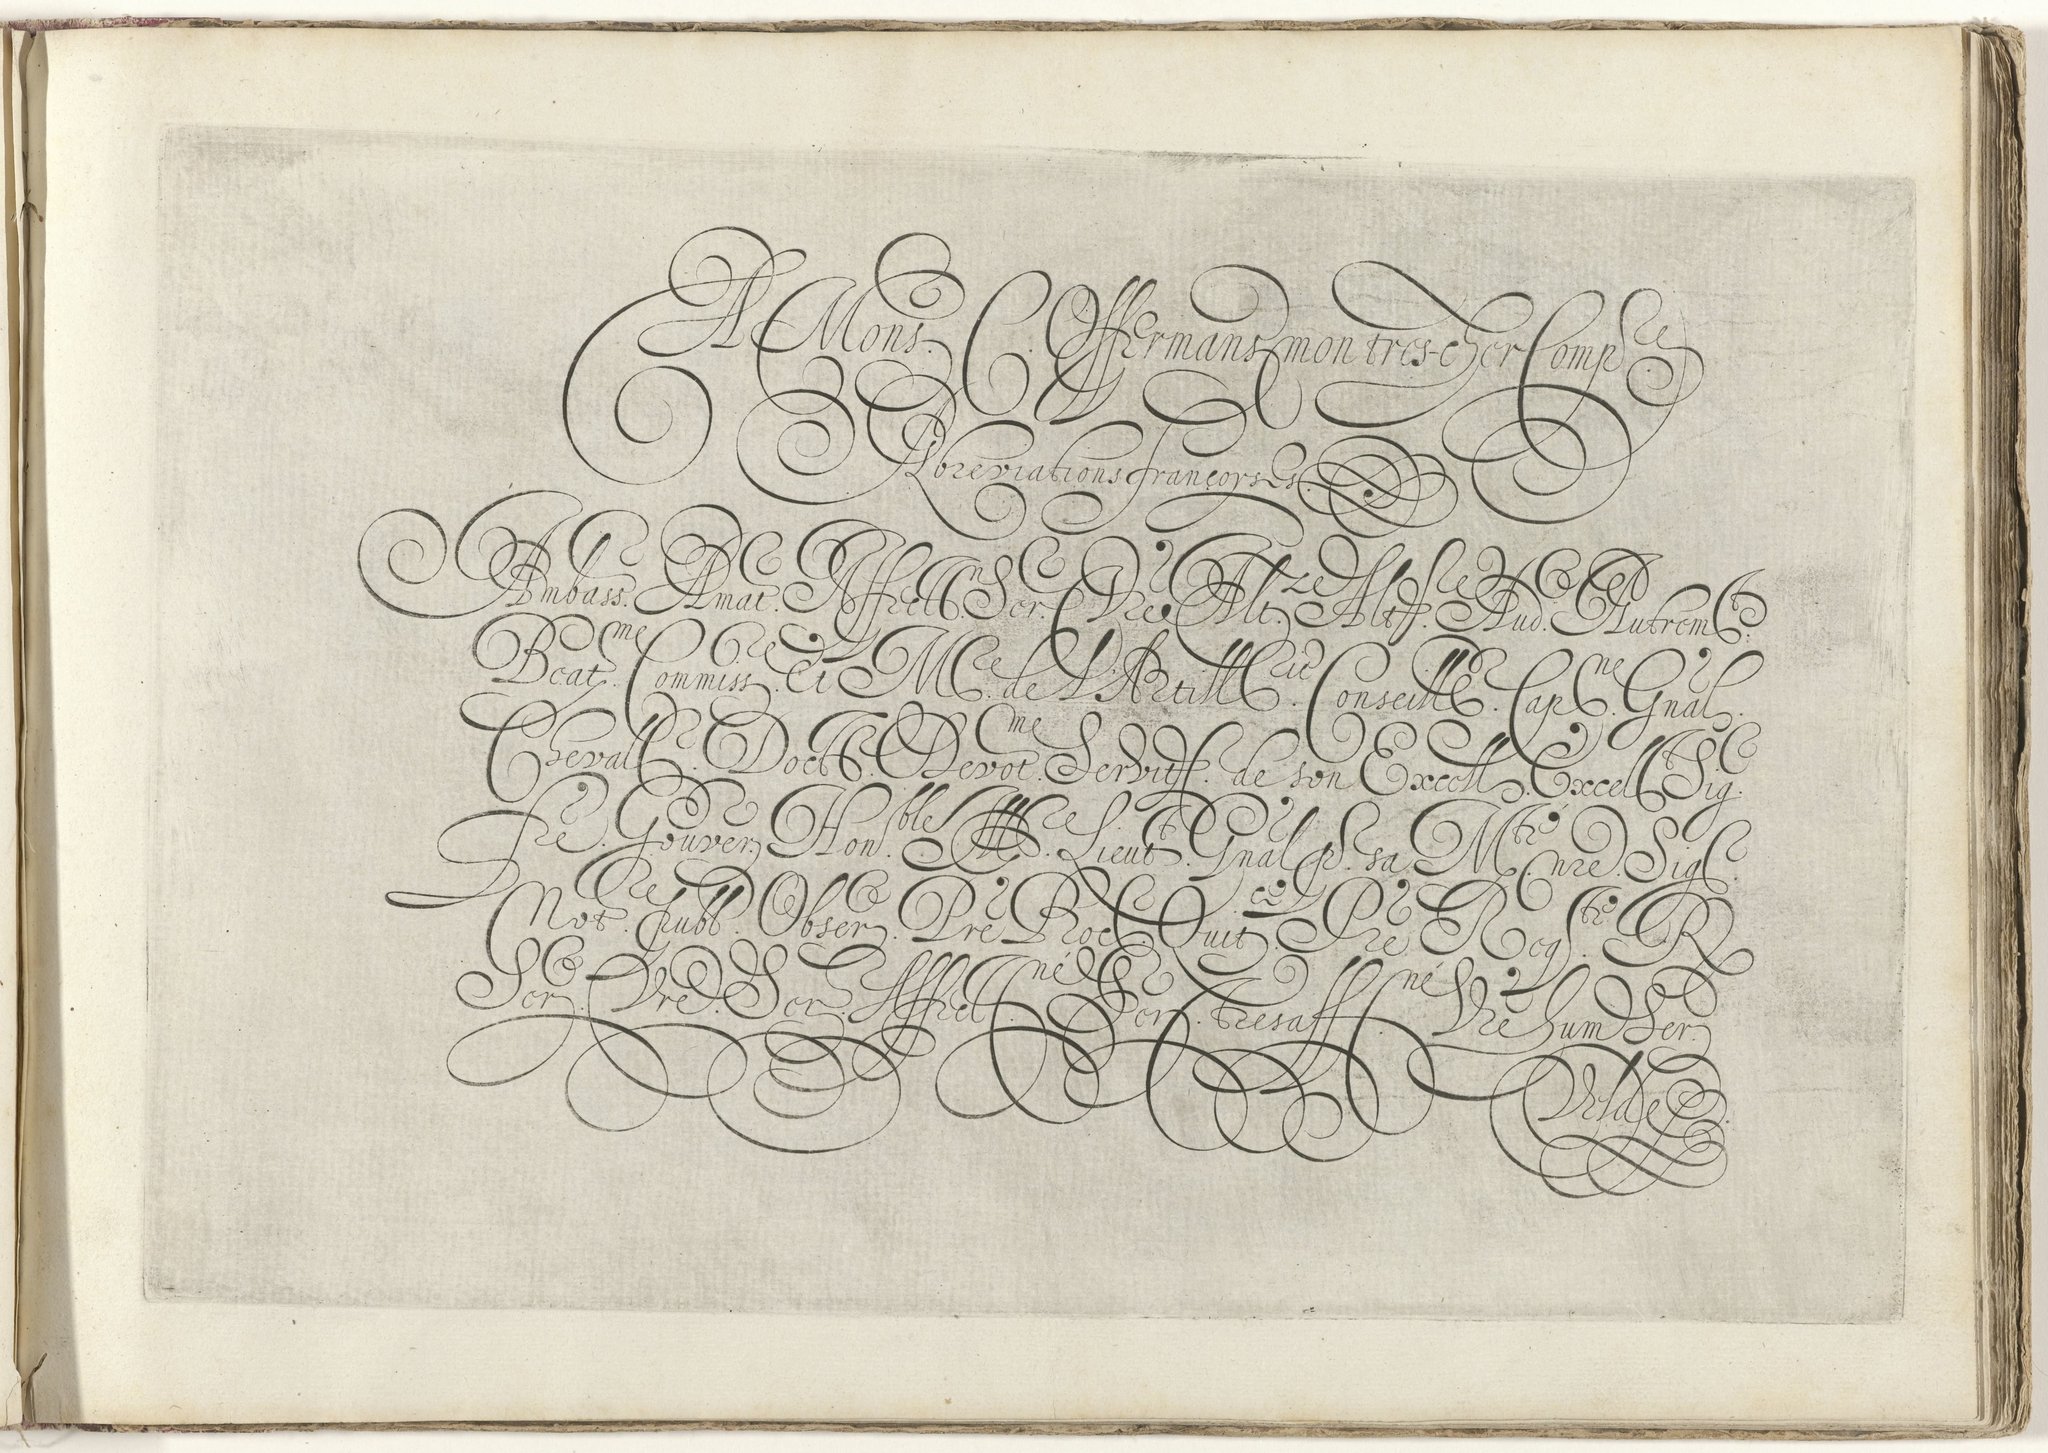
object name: ornament print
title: Schrijfvoorbeeld: A mons. C. Offermans (...)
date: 1605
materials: paper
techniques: engraving, intaglio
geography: rotterdam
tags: calligraphy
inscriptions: collector's mark: Lugt 2760, collector's mark: Lugt 2228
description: Schrijfvoorbeeld met de aanhef: A mons. C. Offermans ... Daaronder zes regels tekst in het Latijn, voornamelijk bestaande uit afkortingen: Ambass. Amat. ... De prent maakt deel uit van een album.